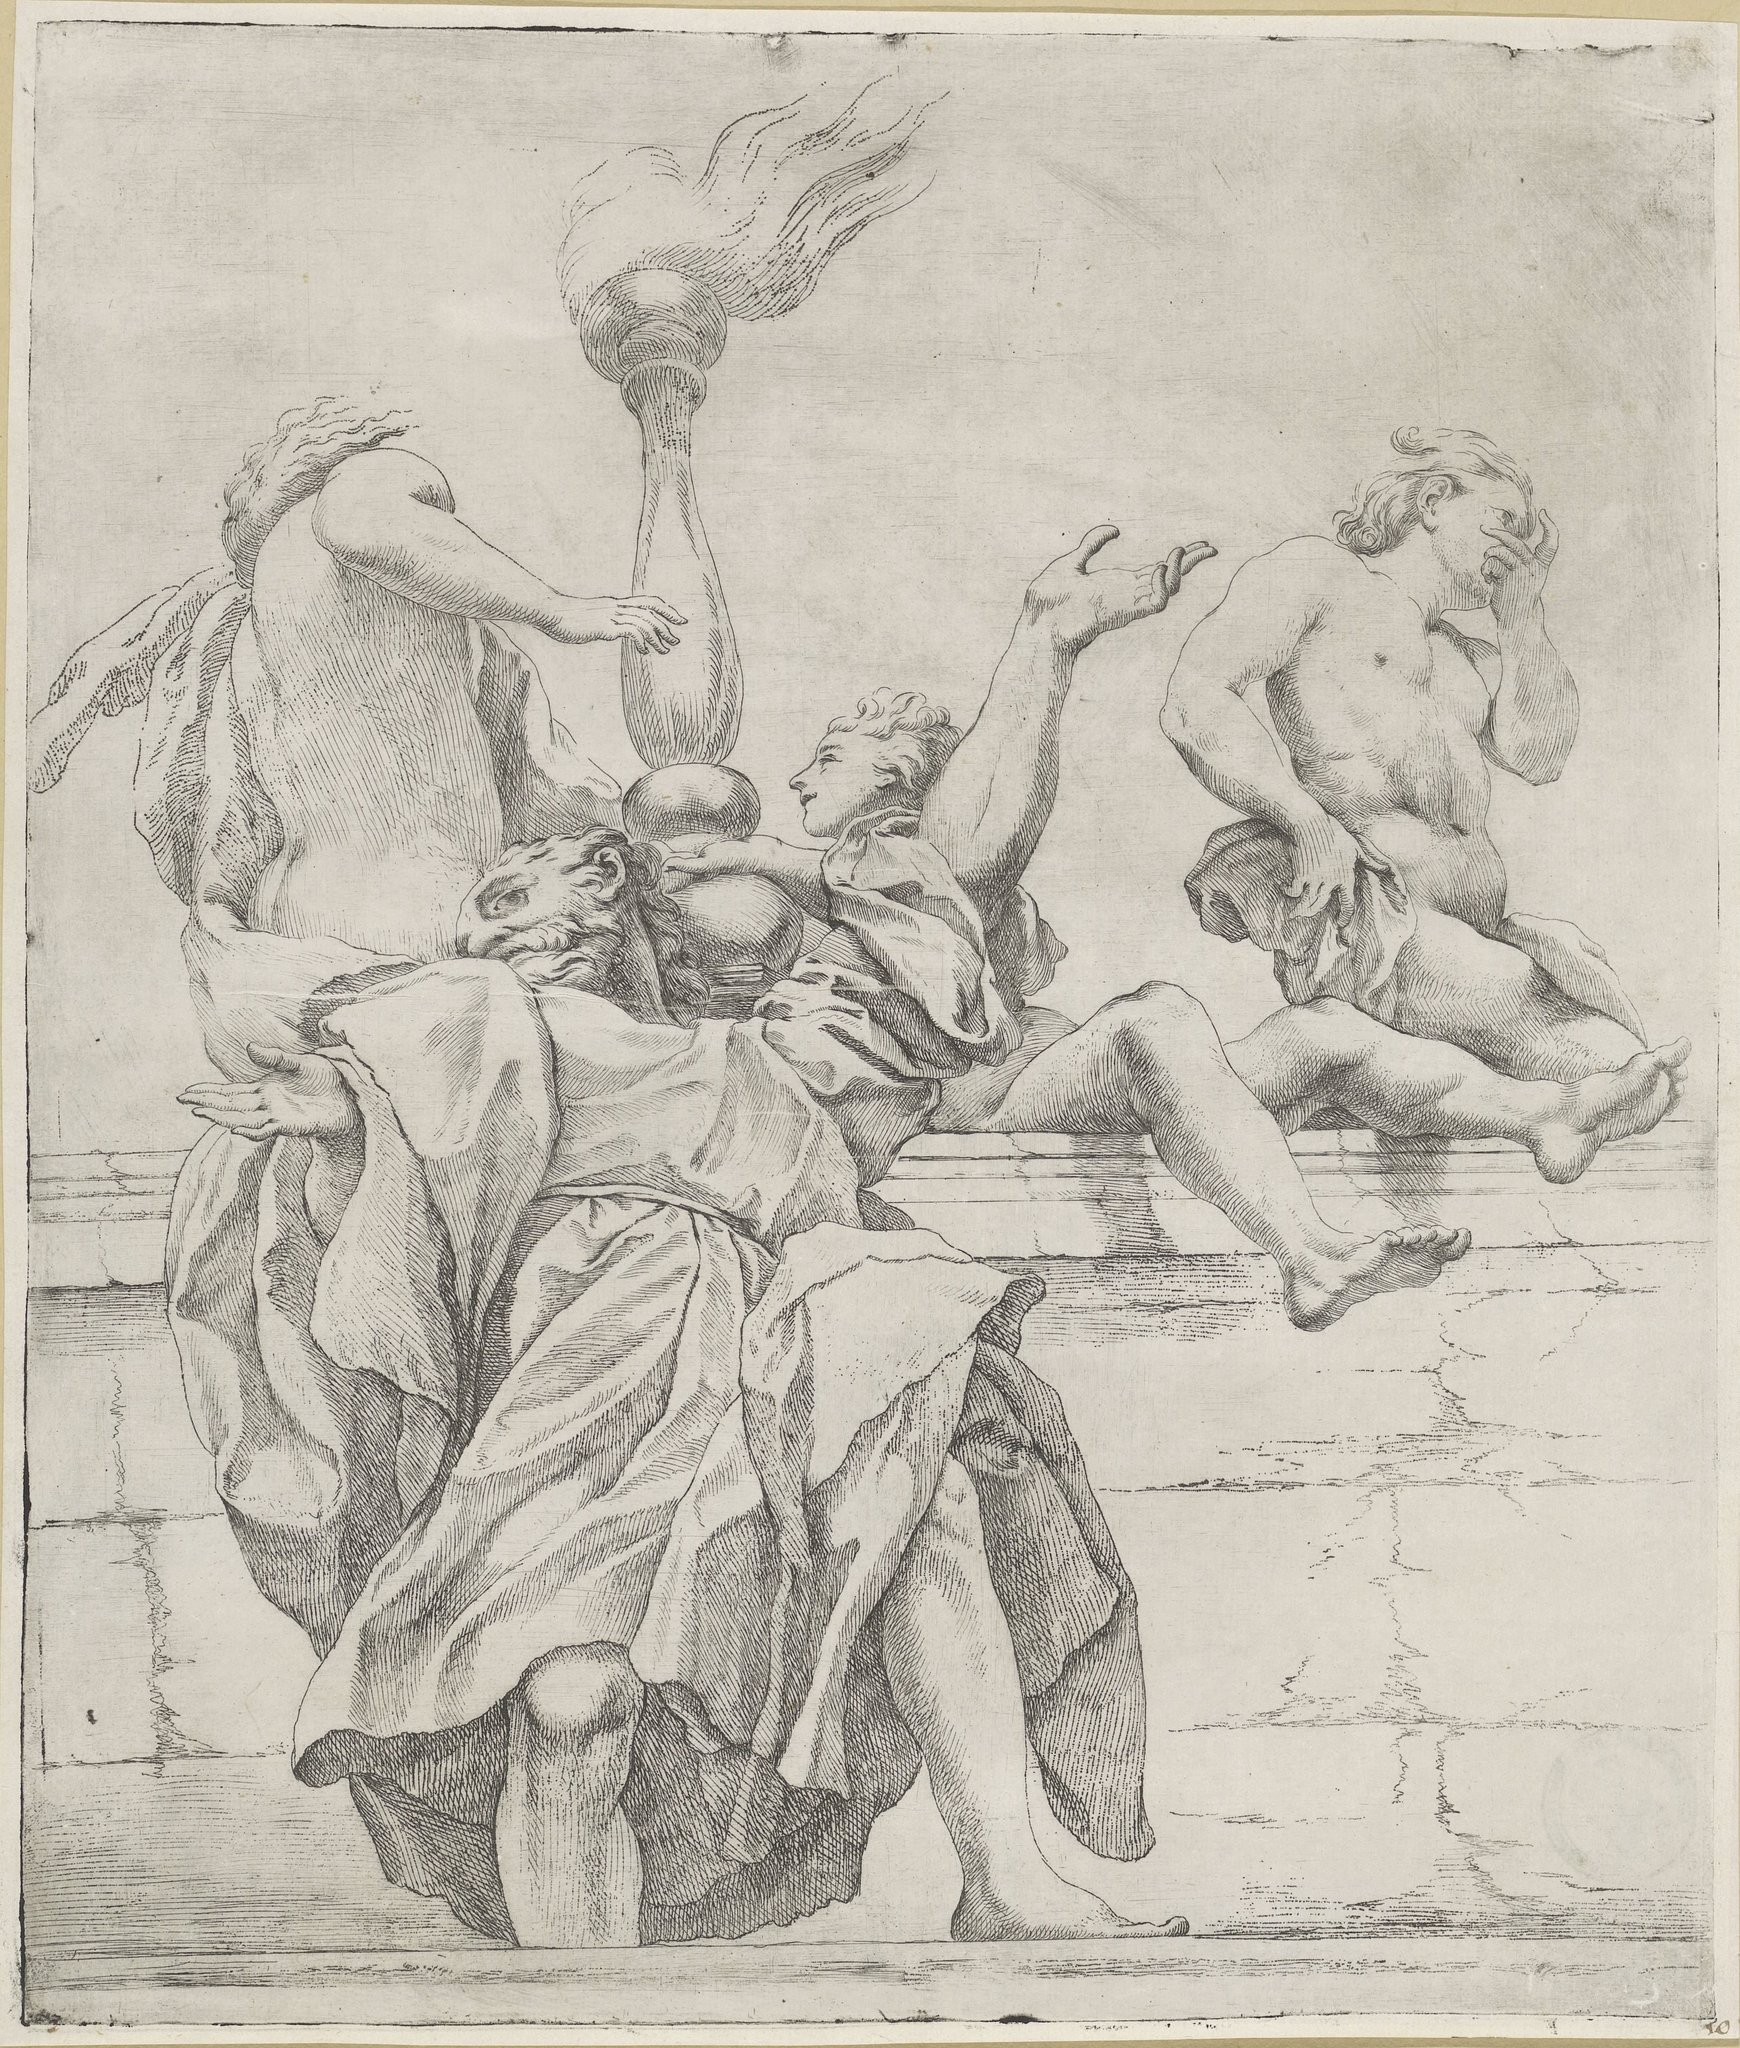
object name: print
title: Koepeldecoraties door Correggio in de S. Giovanni Evangelista in Parma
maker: giovanni battista vanni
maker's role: print maker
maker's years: 1599-1660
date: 1609-1660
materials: paper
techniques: etching, intaglio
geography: parma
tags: (single) apostle, unspecified, angels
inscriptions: collector's mark: Lugt 10, collector's mark: Lugt 11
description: Prent uit een reeks van 8 prenten naar de koepeldecoraties door Correggio in de S. Giovanni Evangelista in Parma.